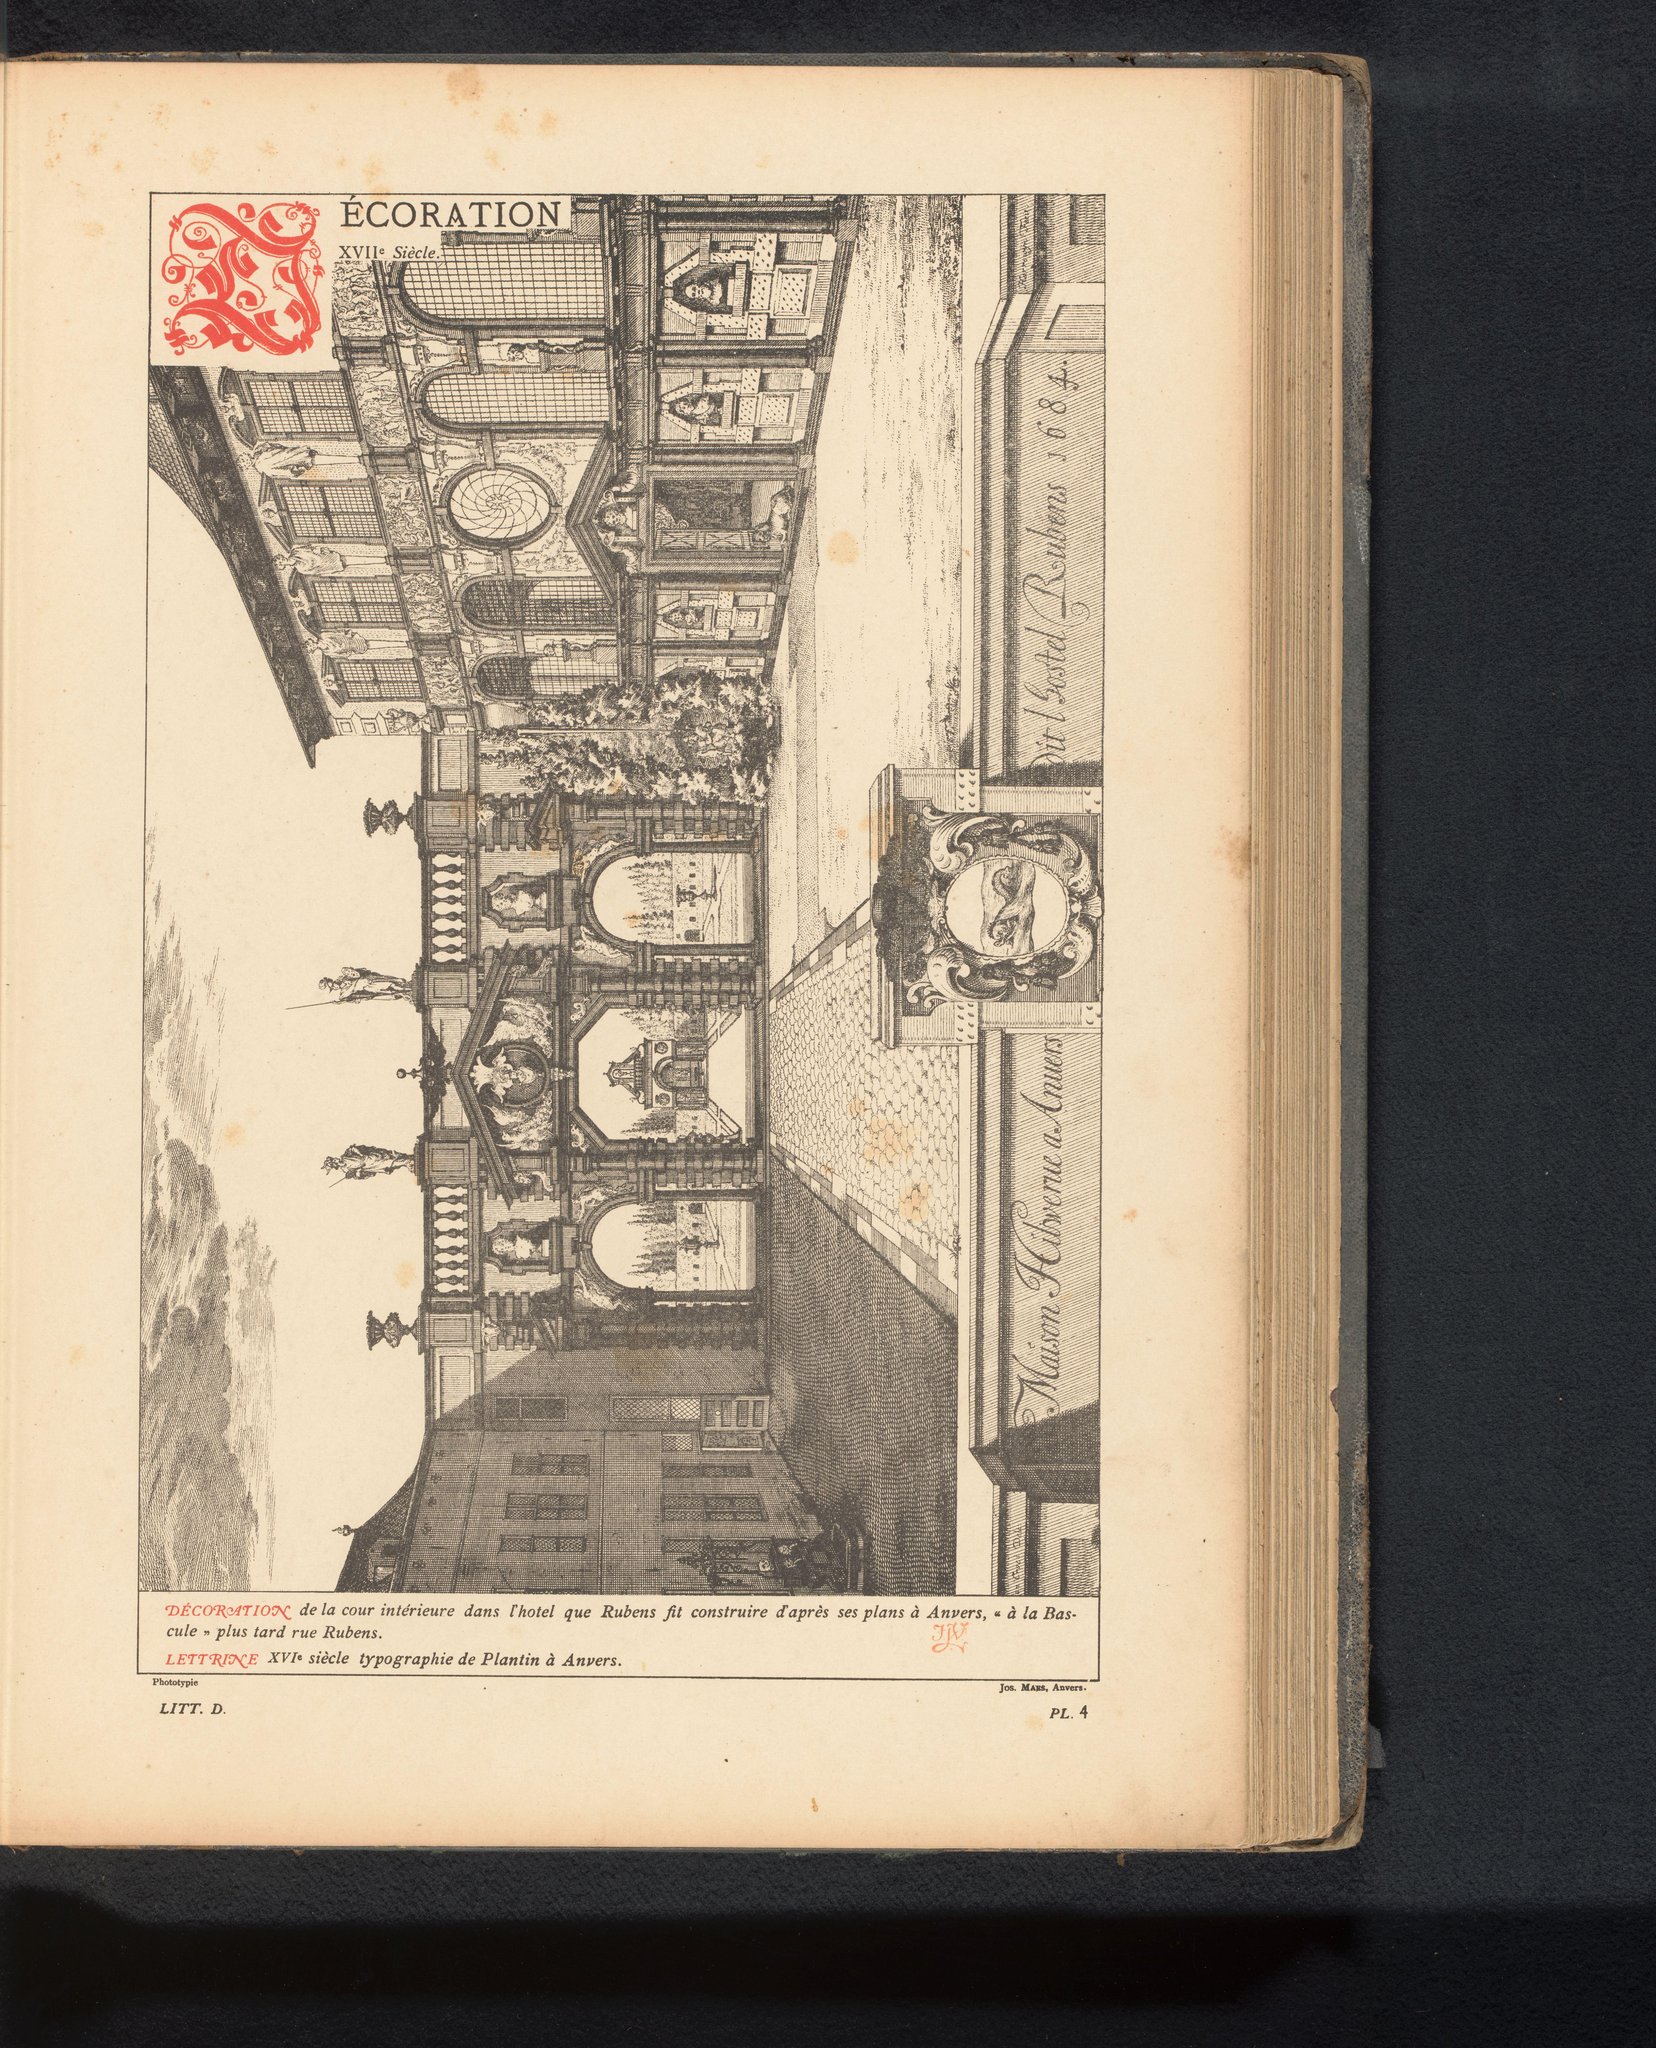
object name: photomechanical print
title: Décoration, XVIIe Siècle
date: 1875-1880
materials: paper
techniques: photolithography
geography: antwerp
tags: urban housing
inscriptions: monogram: ‘JJvY’, inscription: ‘DÉCORATION de la (...)’, inscription: ‘LITT. D. - PL. 4’